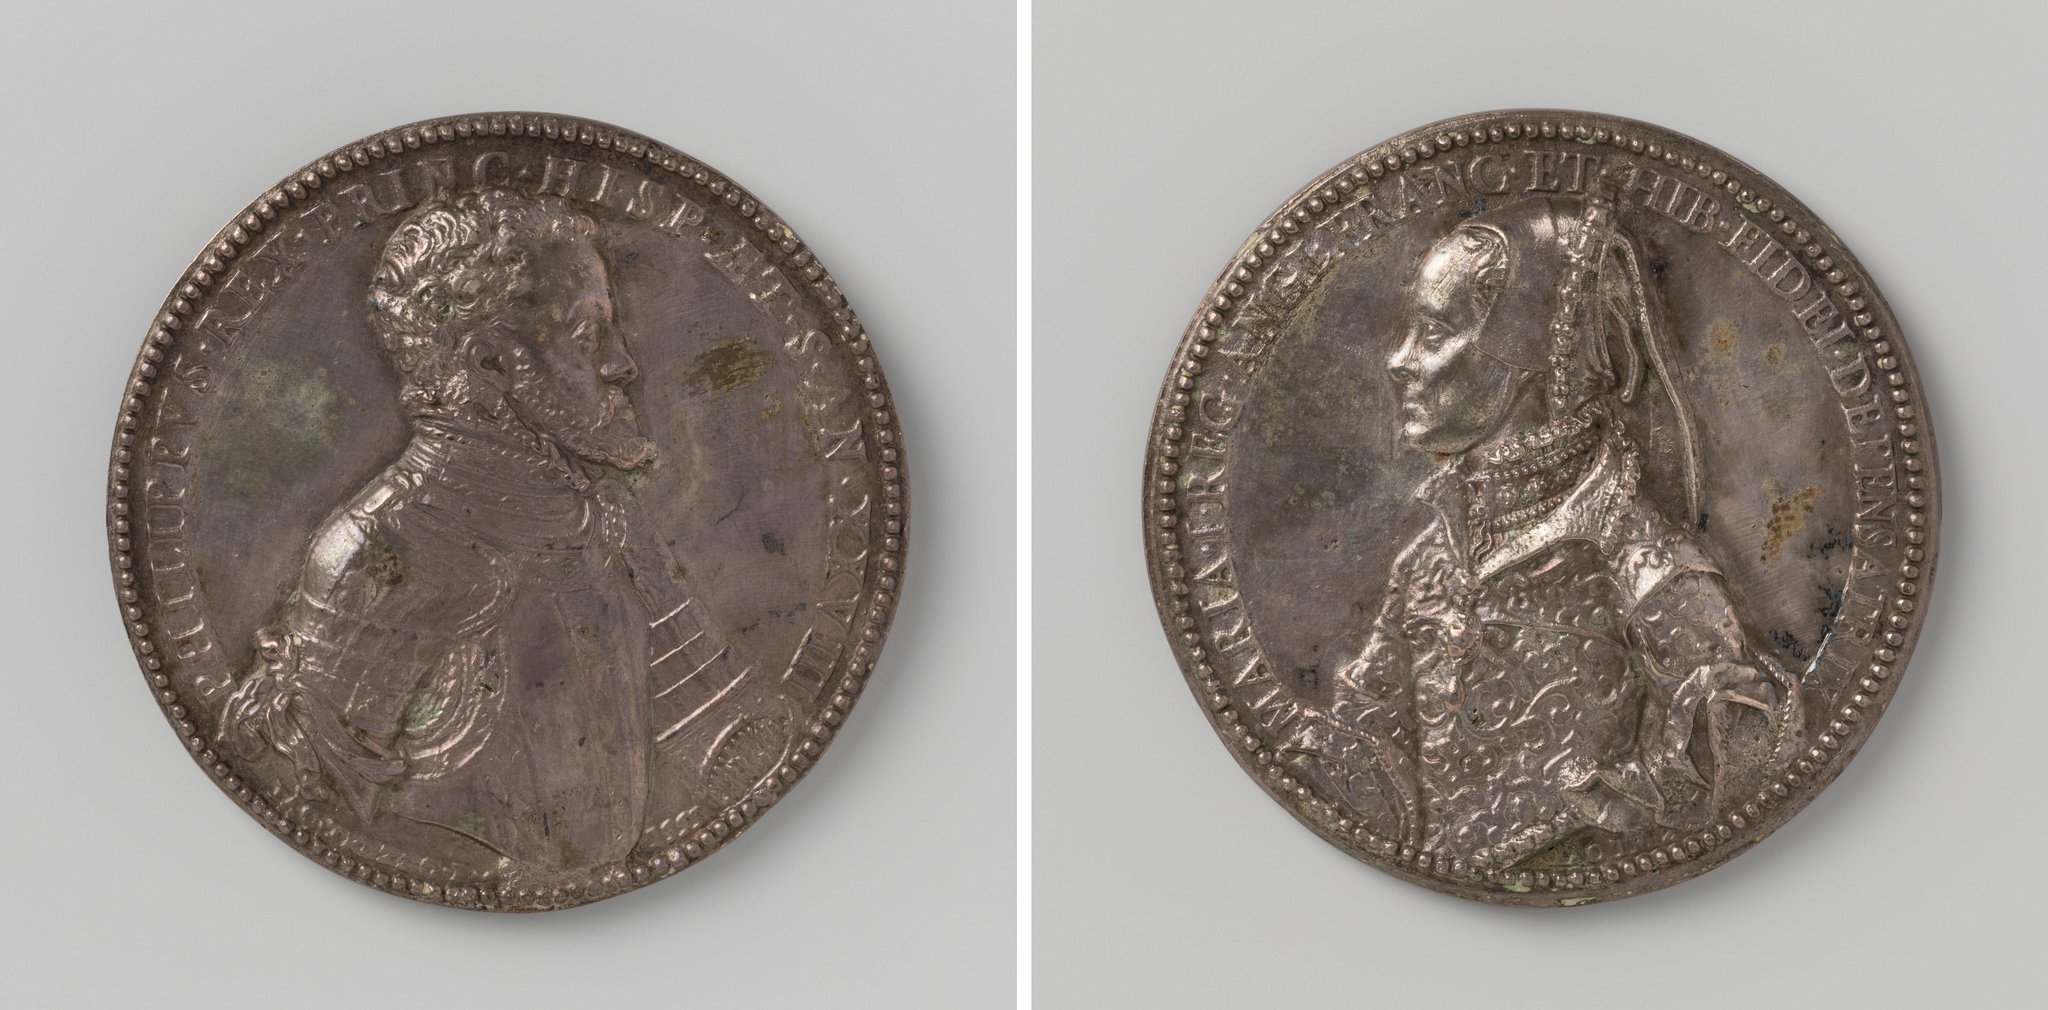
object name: history medal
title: Filips II van Spanje en Maria I van Engeland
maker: jacopo nizzola da trezzo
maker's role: medailleur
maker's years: 1515-1589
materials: silver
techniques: casting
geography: brussels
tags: philip ii of spain, london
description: Zilveren penning. Voorzijde: borststuk man binnen omschrift. Keerzijde: borststuk vrouw binnen omschrift